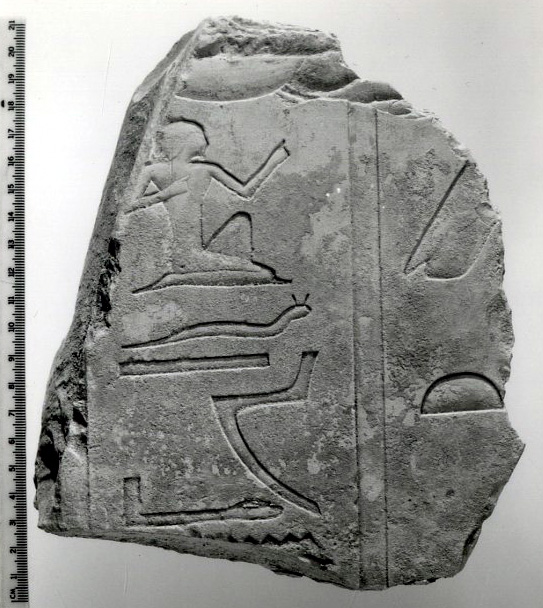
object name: relief fragment, tomb of meketre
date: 1981-1975 BCE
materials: limestone, paint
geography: egypt